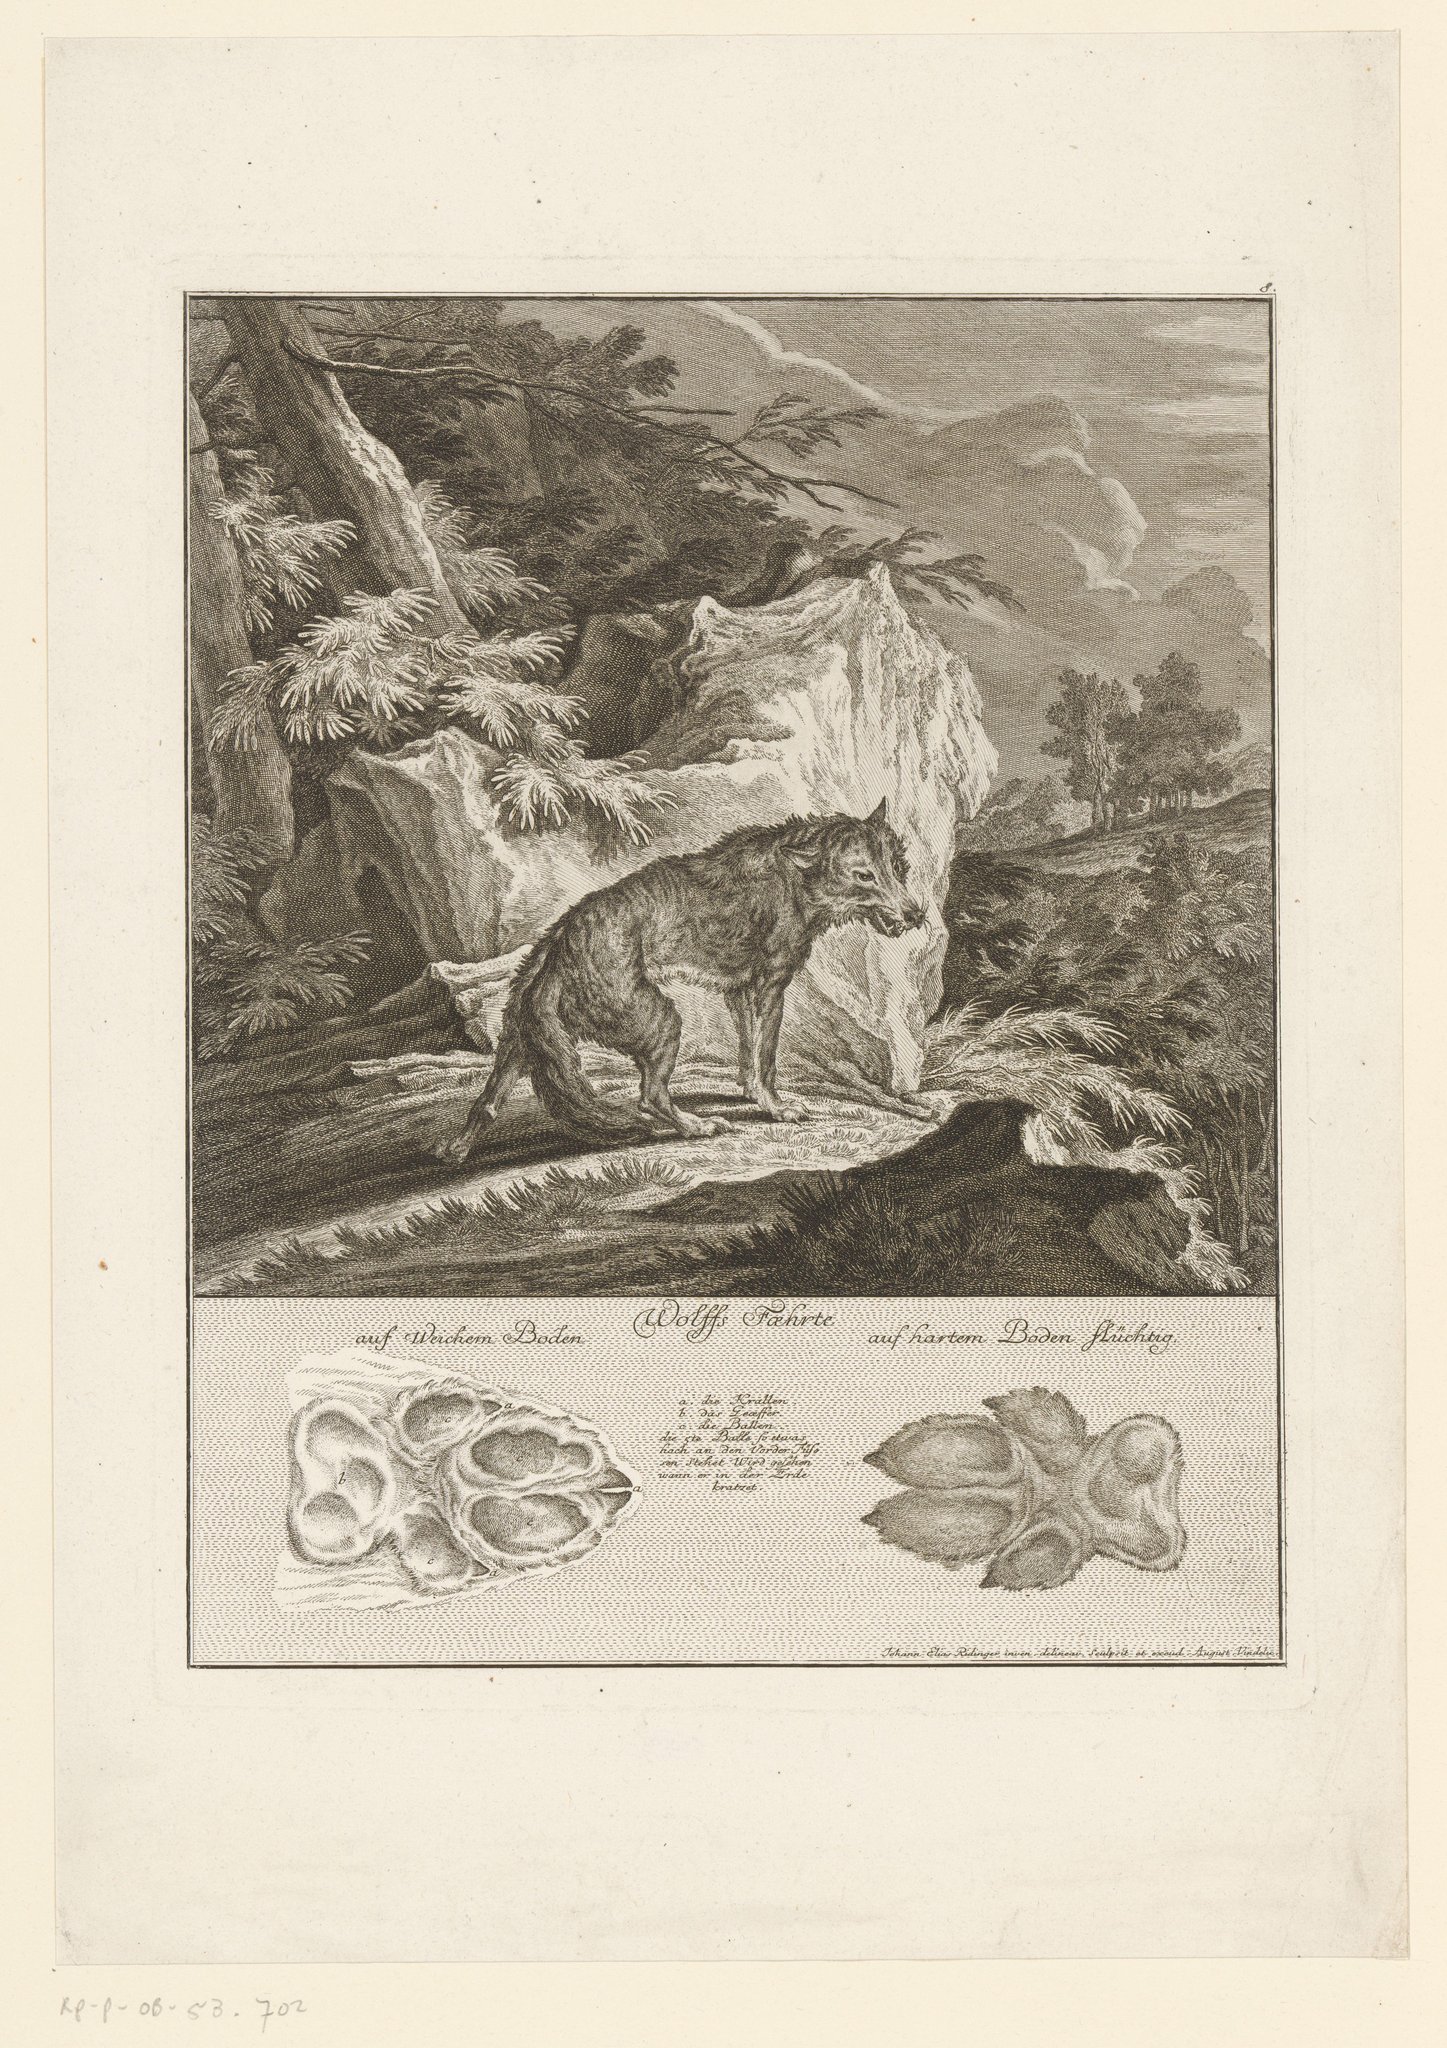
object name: print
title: Wolf met spoor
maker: johann elias ridinger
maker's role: draughtsman, painter, print maker, publisher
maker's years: 1698-1767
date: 1751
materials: paper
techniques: etching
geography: augsburg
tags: foot-print, track, forest, wood, hunt ~ mammals, beasts of prey, predatory animals: wolf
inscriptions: collector's mark: Lugt 2228